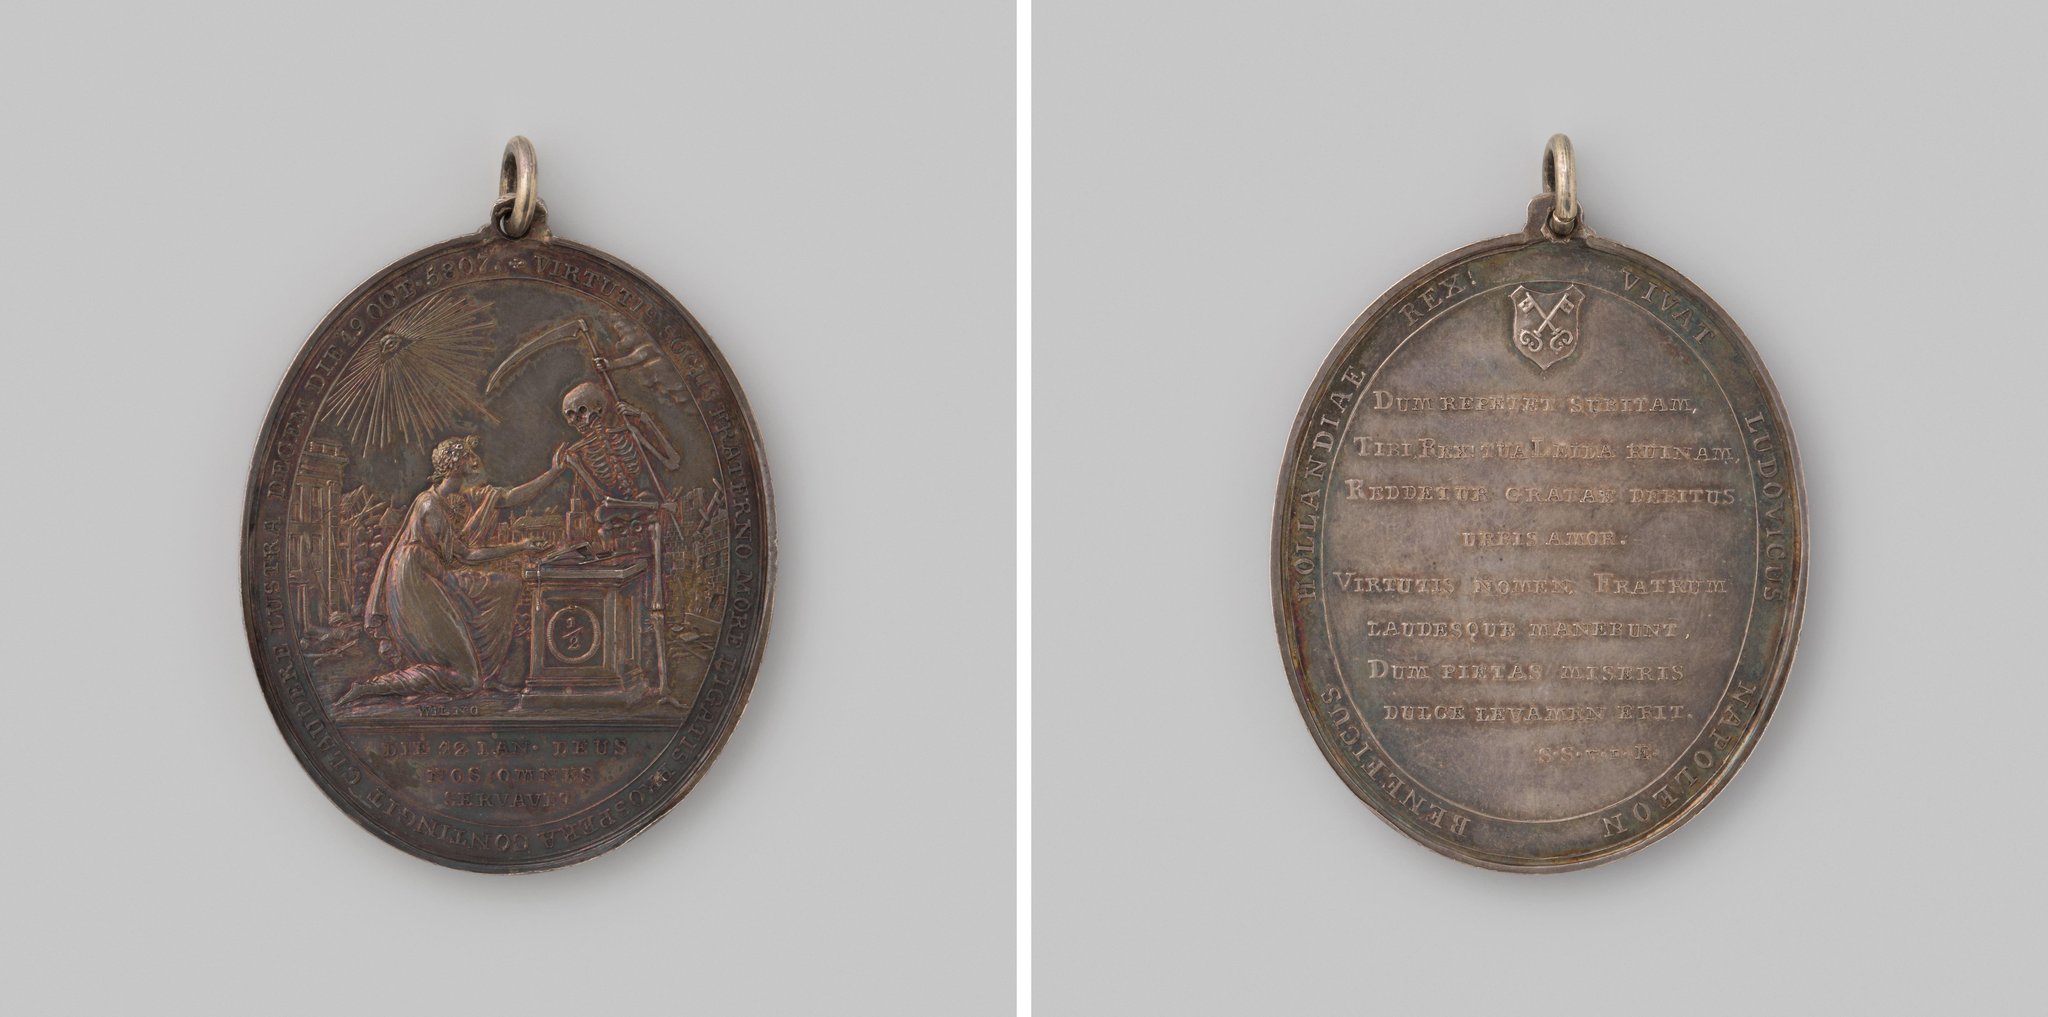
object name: medal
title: De buskruitramp te Leiden herdacht bij het vijftigjarig bestaan van de Loge der Vrijmetselaars La Vertu te Leiden 1807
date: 1807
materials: silver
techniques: striking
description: Ovalen zilveren penning met oog en draagring, op de voorzijde Leiden als vrouw die de Dood afweeert naast een altaar met 1/2 in een slangenrond, op de achtergrond de verwoeste stad onder het stralend oog Gods, met omschrift en afsnedetekst, op de keerzijde acht regels tekst onder een Leids stadswapenschildje, met omschrift.